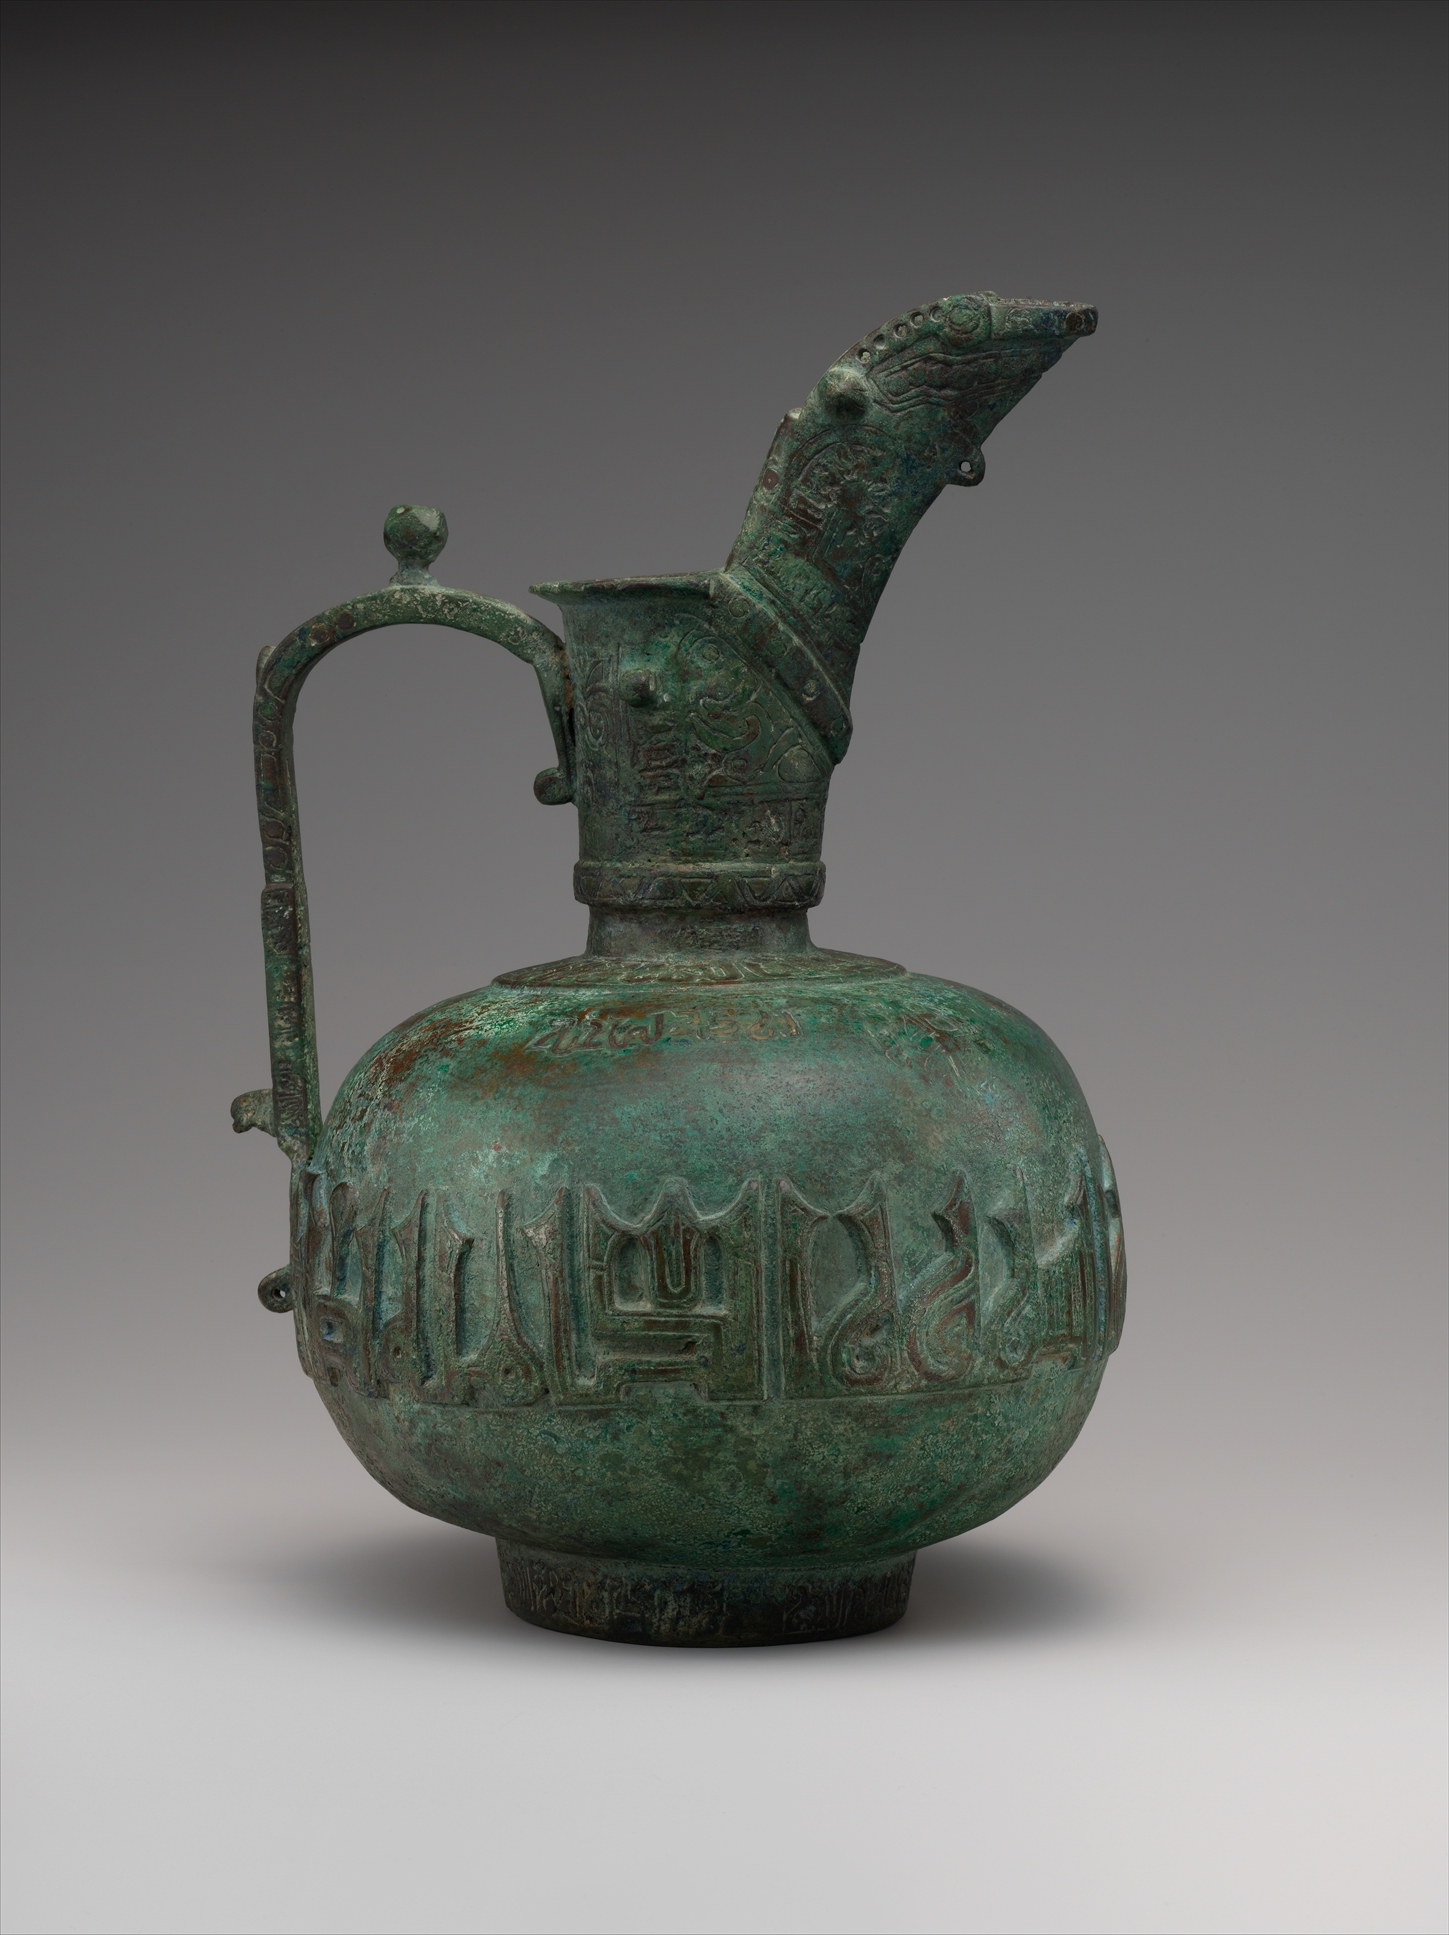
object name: ewer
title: Ewer with Calligraphic Band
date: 1101-1200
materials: bronze, silver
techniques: casting, engraving, inlay, relief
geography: iran